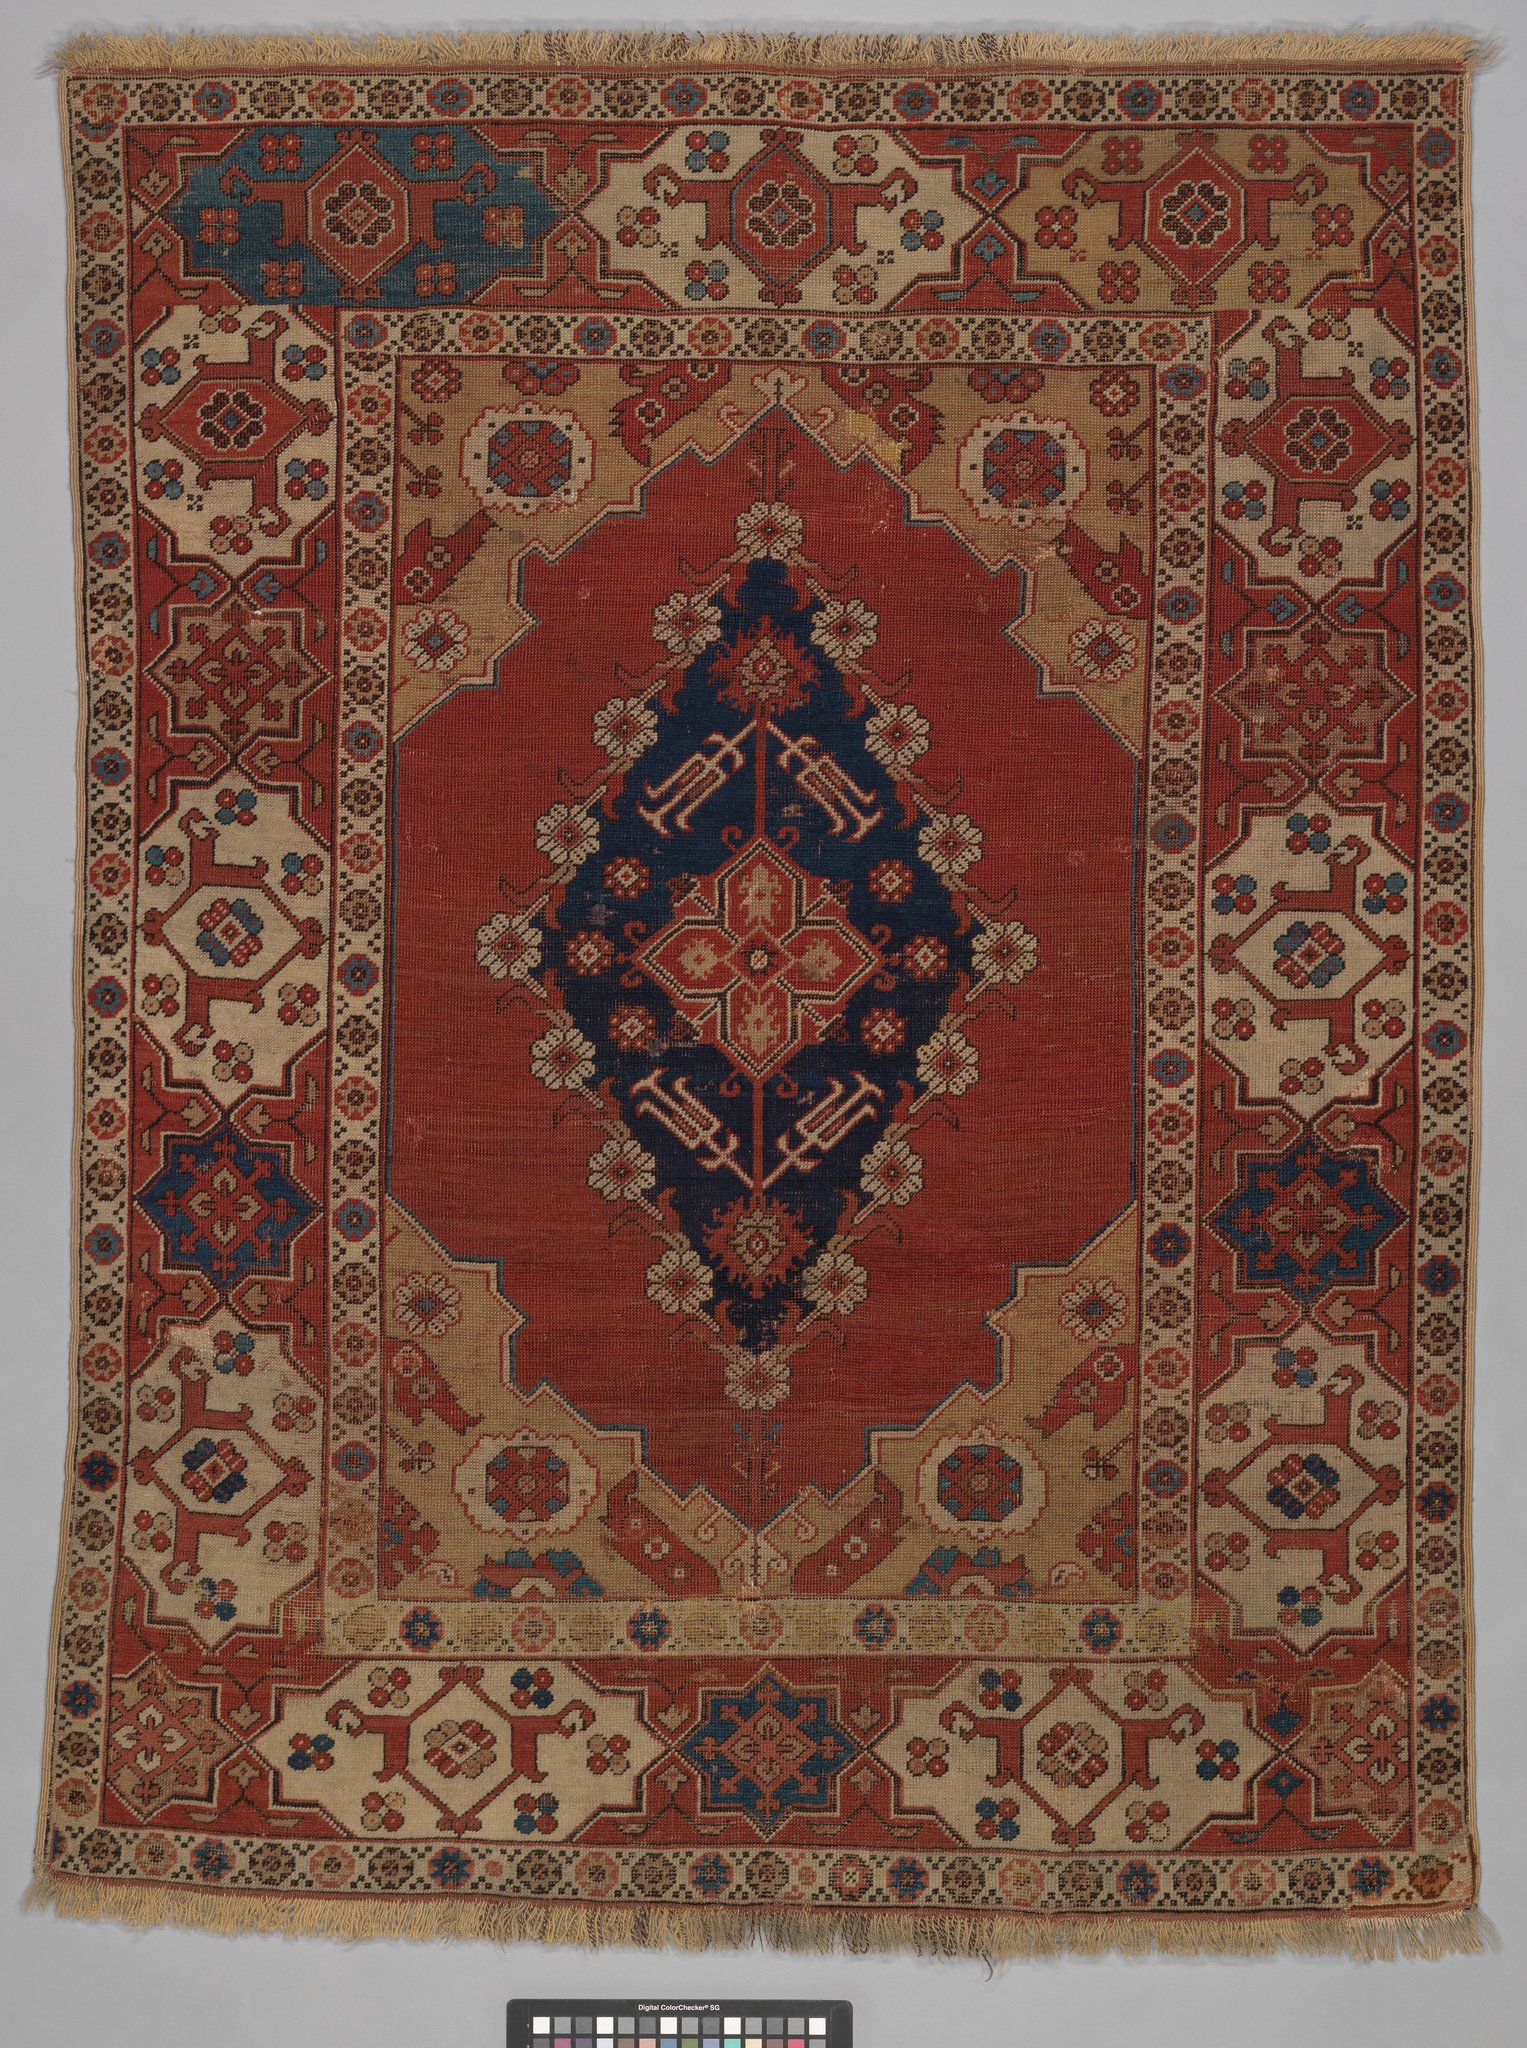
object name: carpet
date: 1701-1800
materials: wool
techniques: pile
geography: turkey